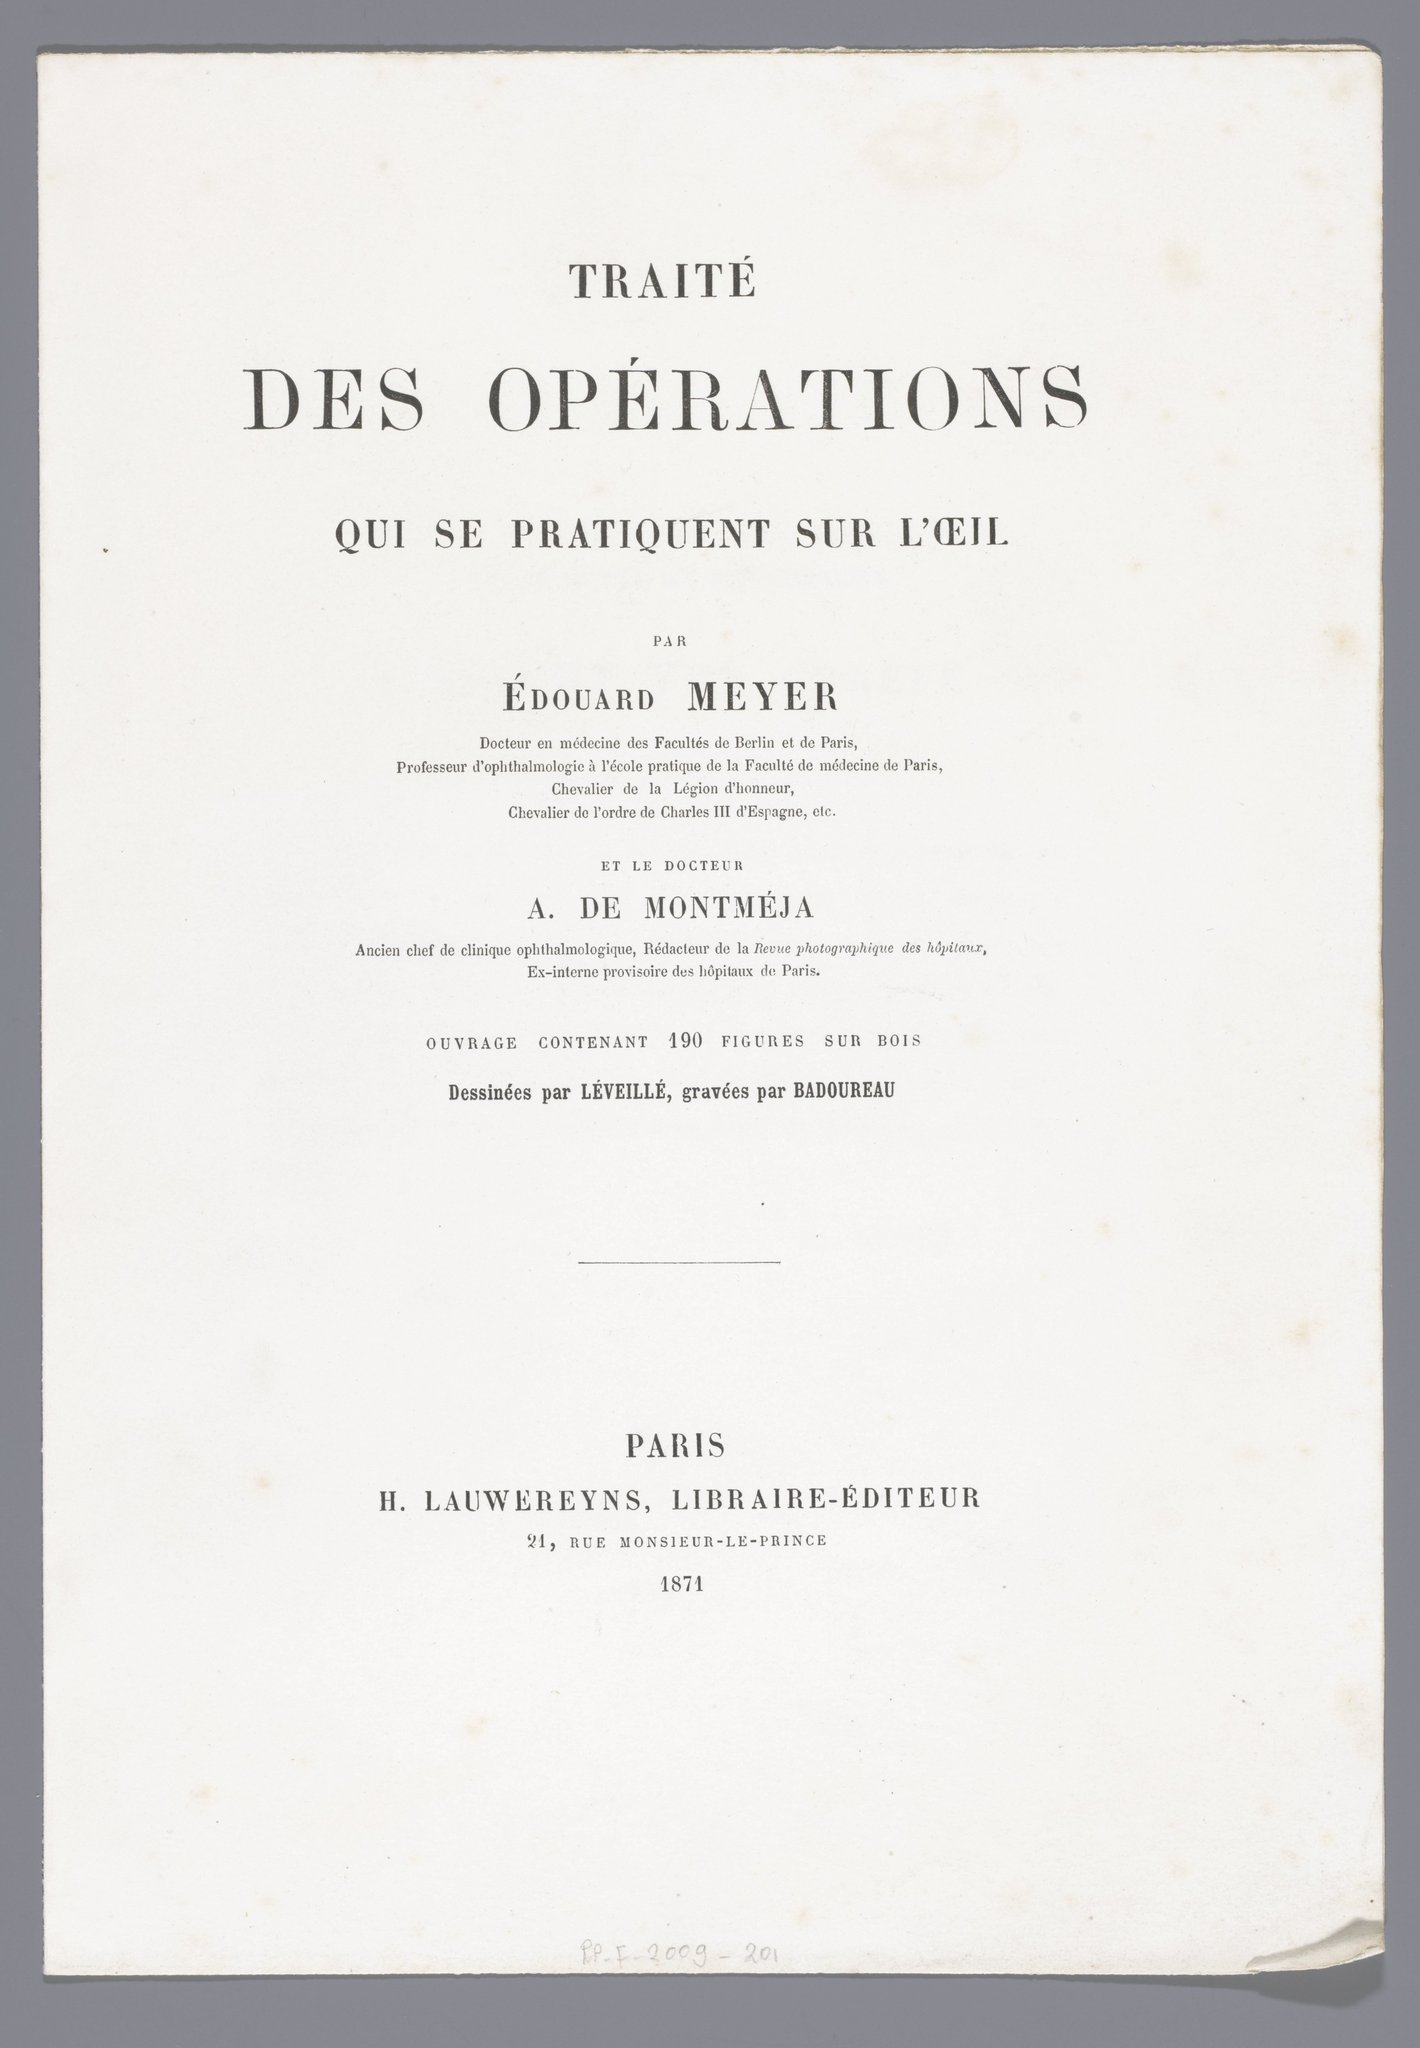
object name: book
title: Traité des opérations qui se pratiquent sur l'oeil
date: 1871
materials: cardboard, paper, photographic support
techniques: albumen print, printing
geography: paris